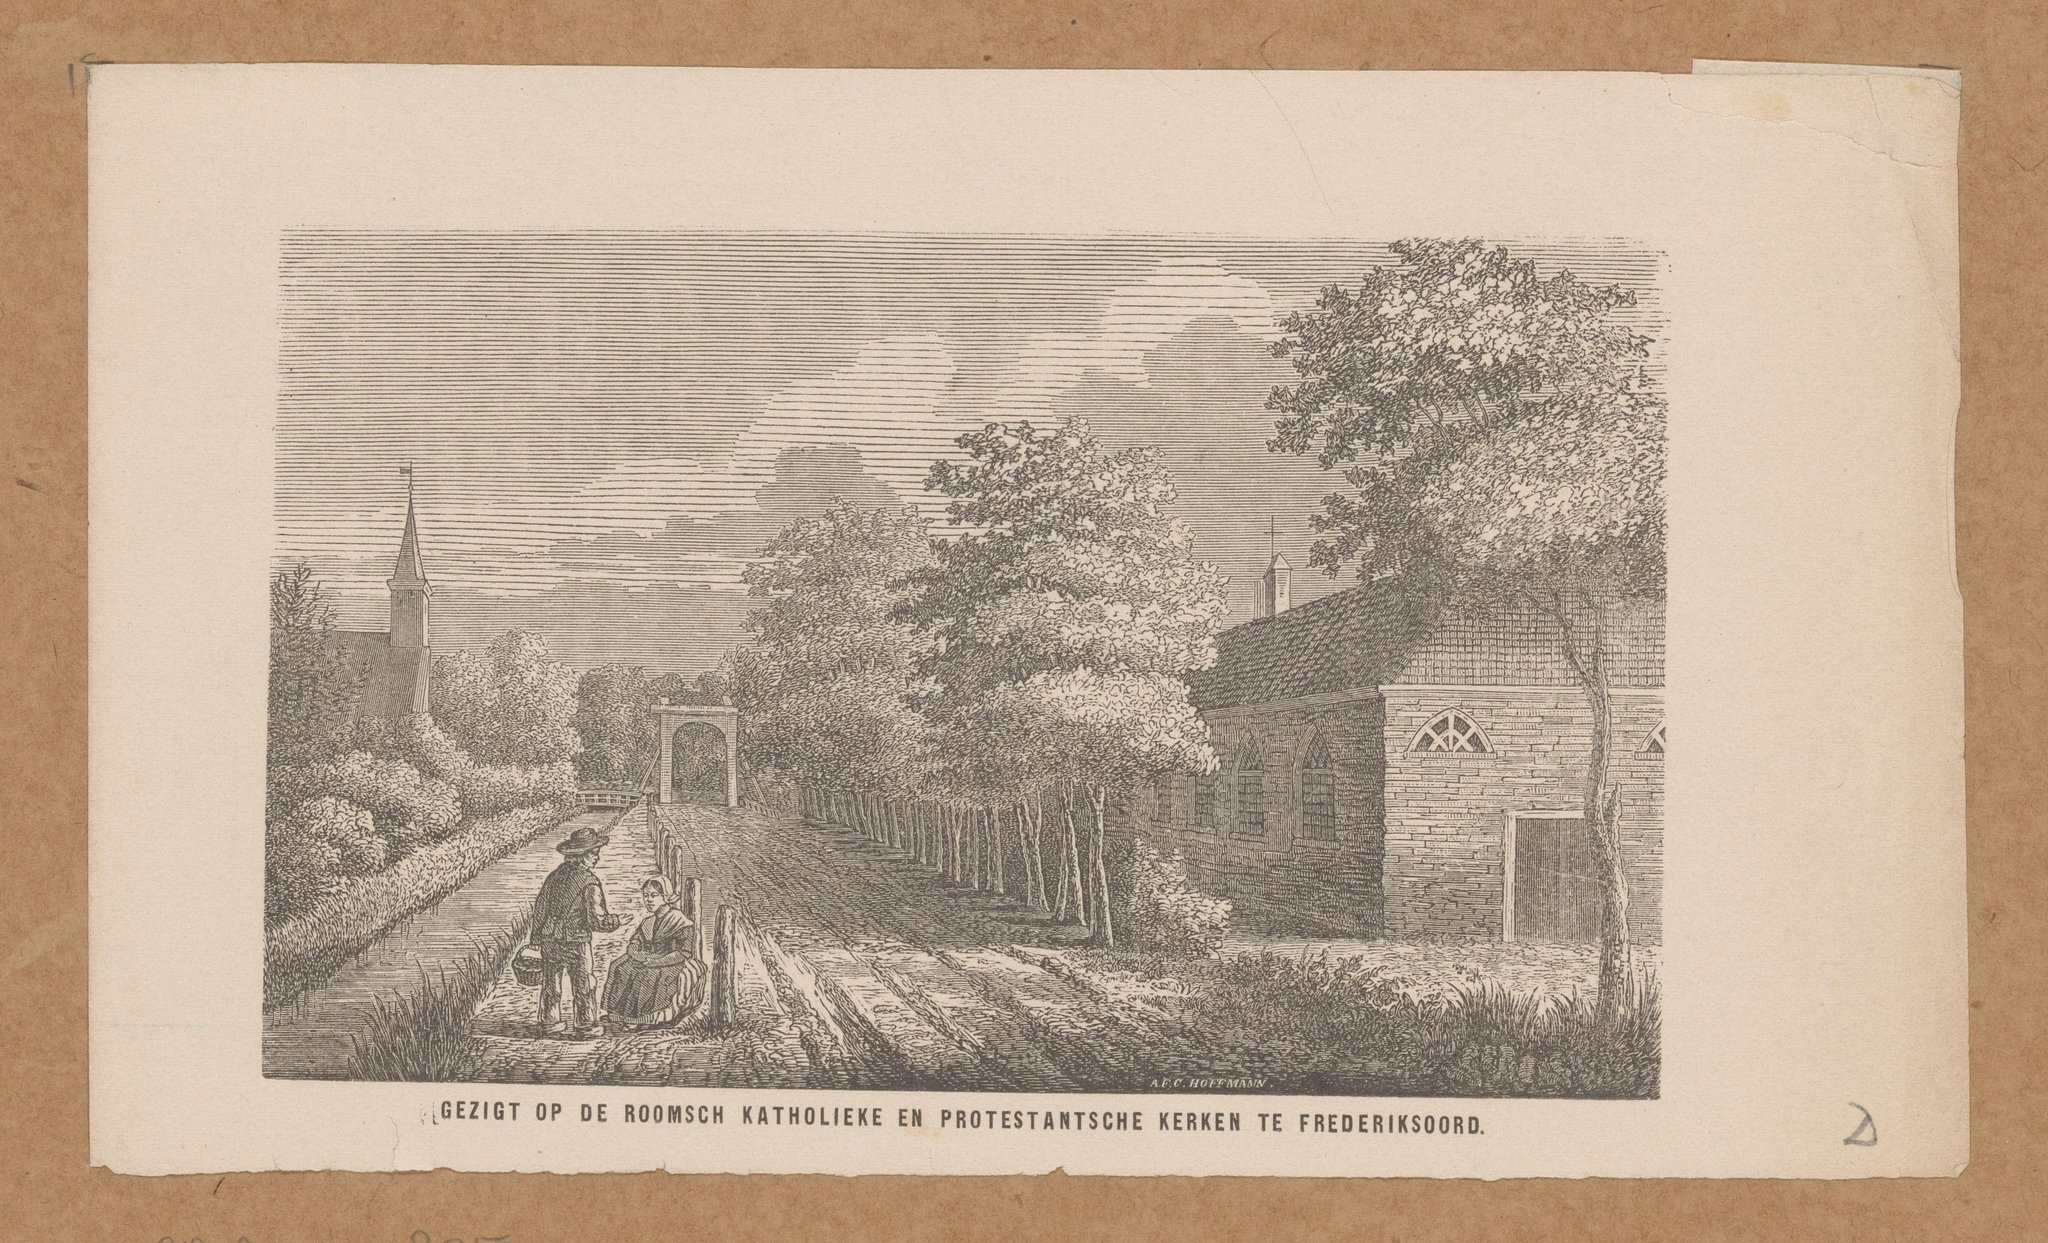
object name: print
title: Gezigt op de Roomsch Katholieke en Protestantsche Kerken te Frederiksoord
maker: antoine franciscus cornelis hoffmann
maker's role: print maker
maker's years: 1822-1889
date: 1832-1889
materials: paper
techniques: engraving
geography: netherlands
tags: protestant churches and denominations, church (exterior), roman catholic church, village (+ city(-scape) with figures, staffage)